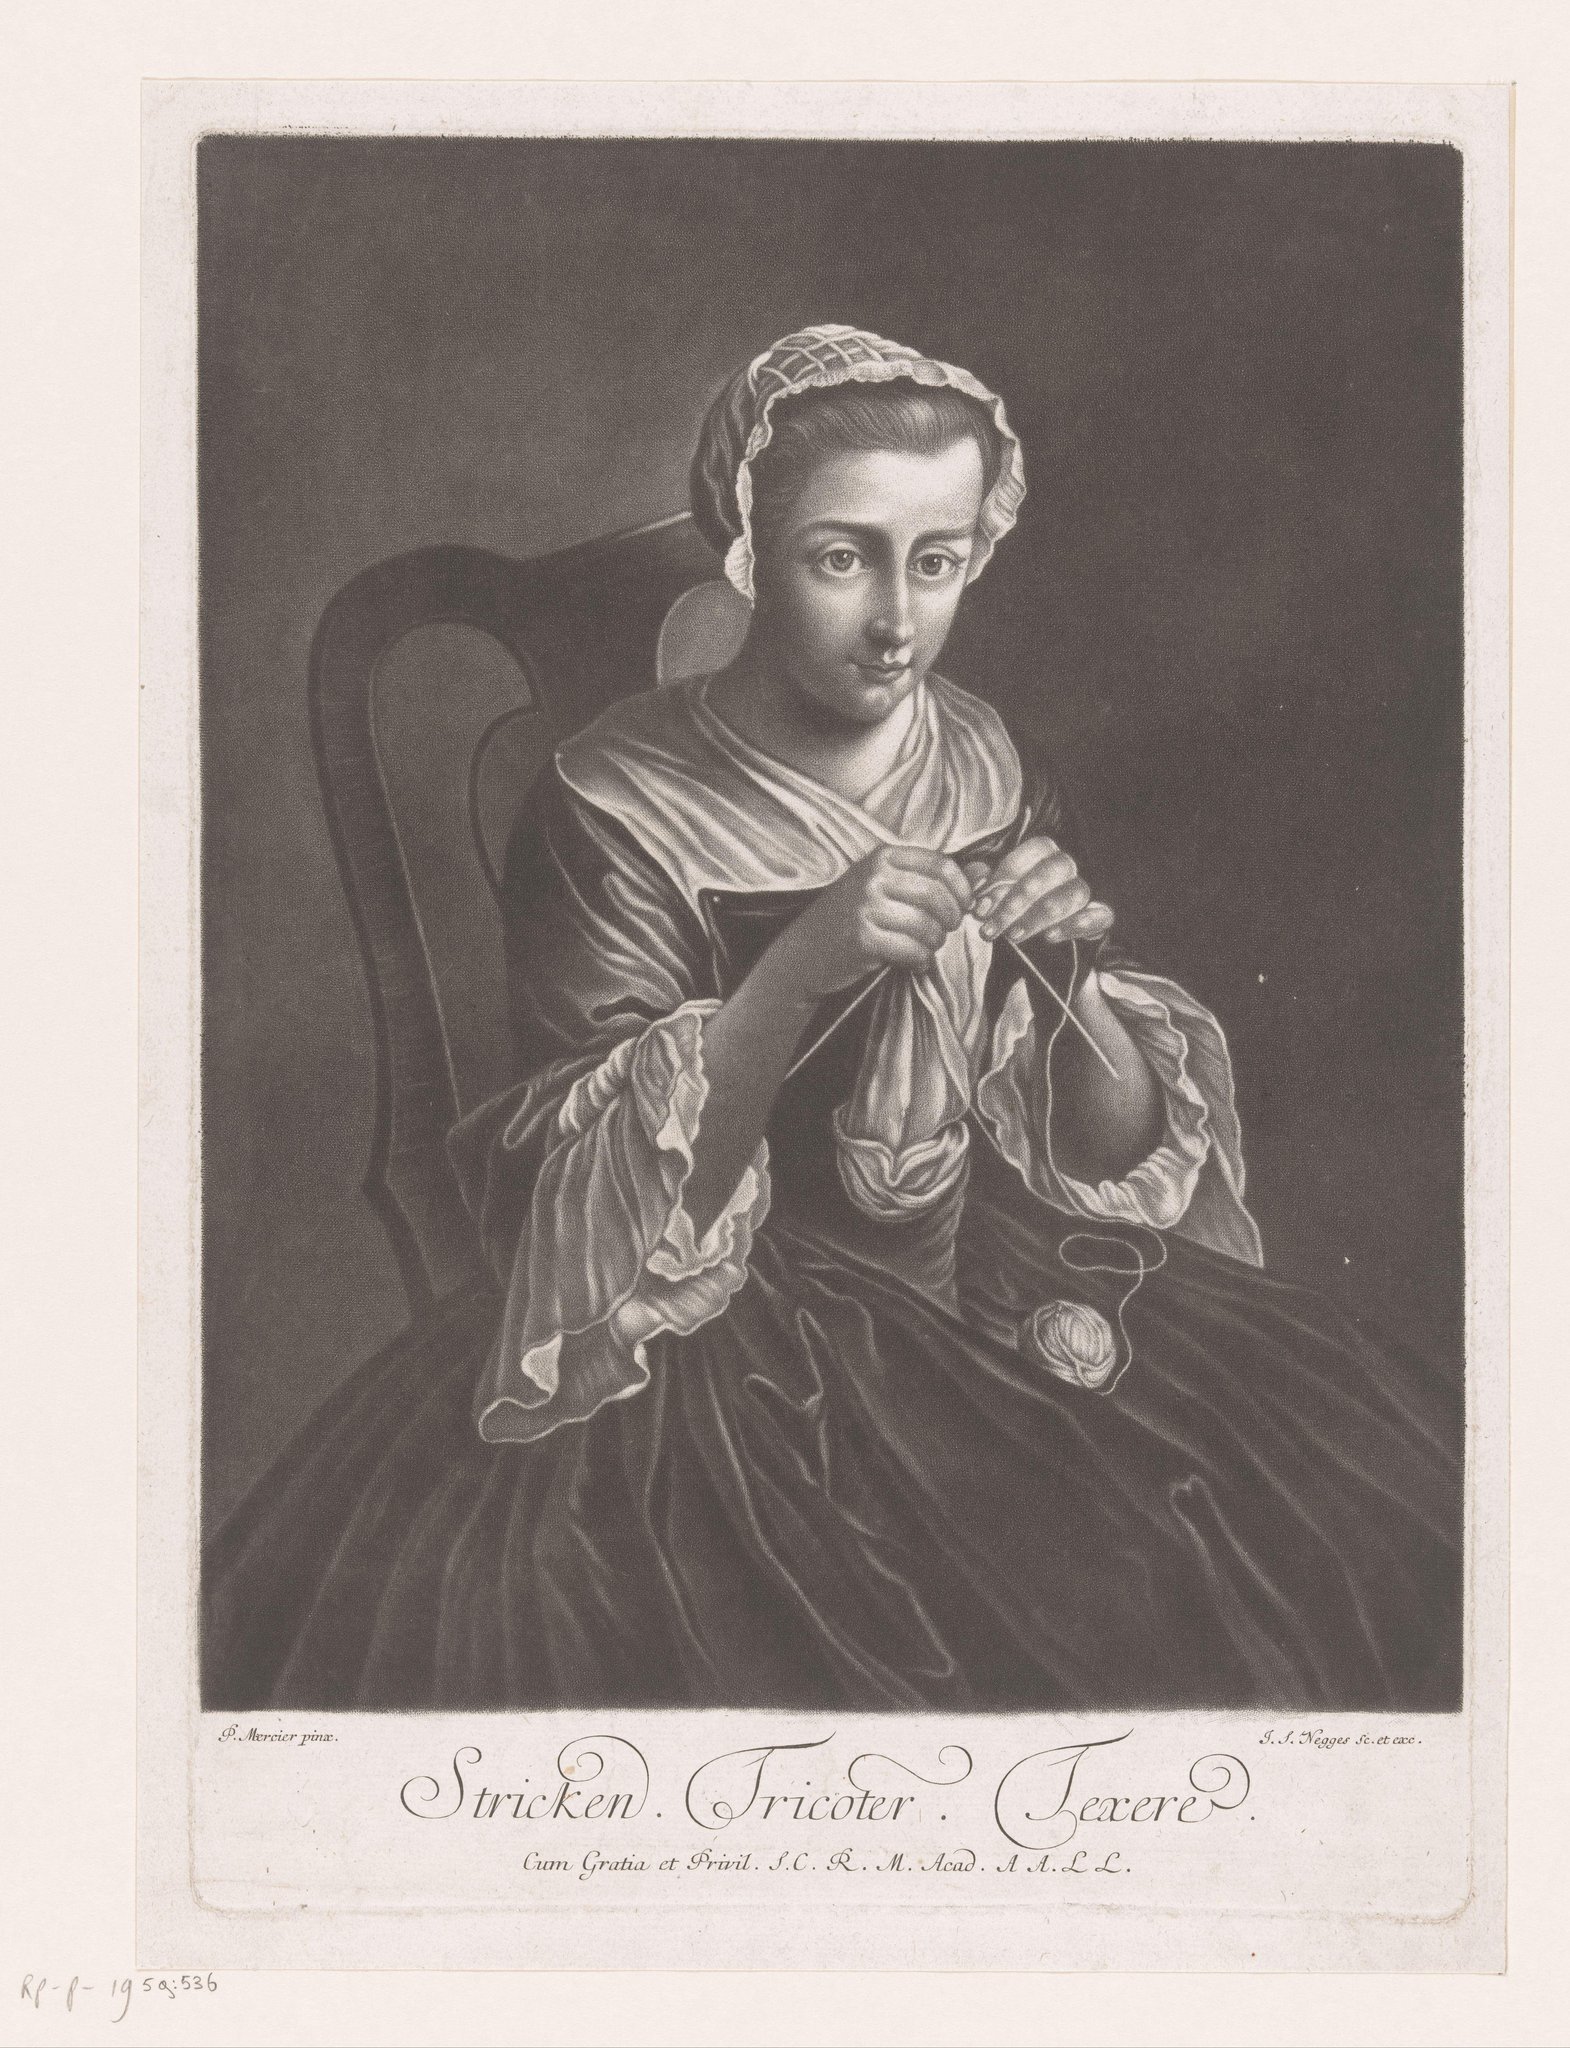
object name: print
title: Vrouw aan het breien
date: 1736-1792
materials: paper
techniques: mezzotint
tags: (other forms of) needlework, e.g.: crocheting, knitting, embroidering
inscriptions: collector's mark: Lugt 2228